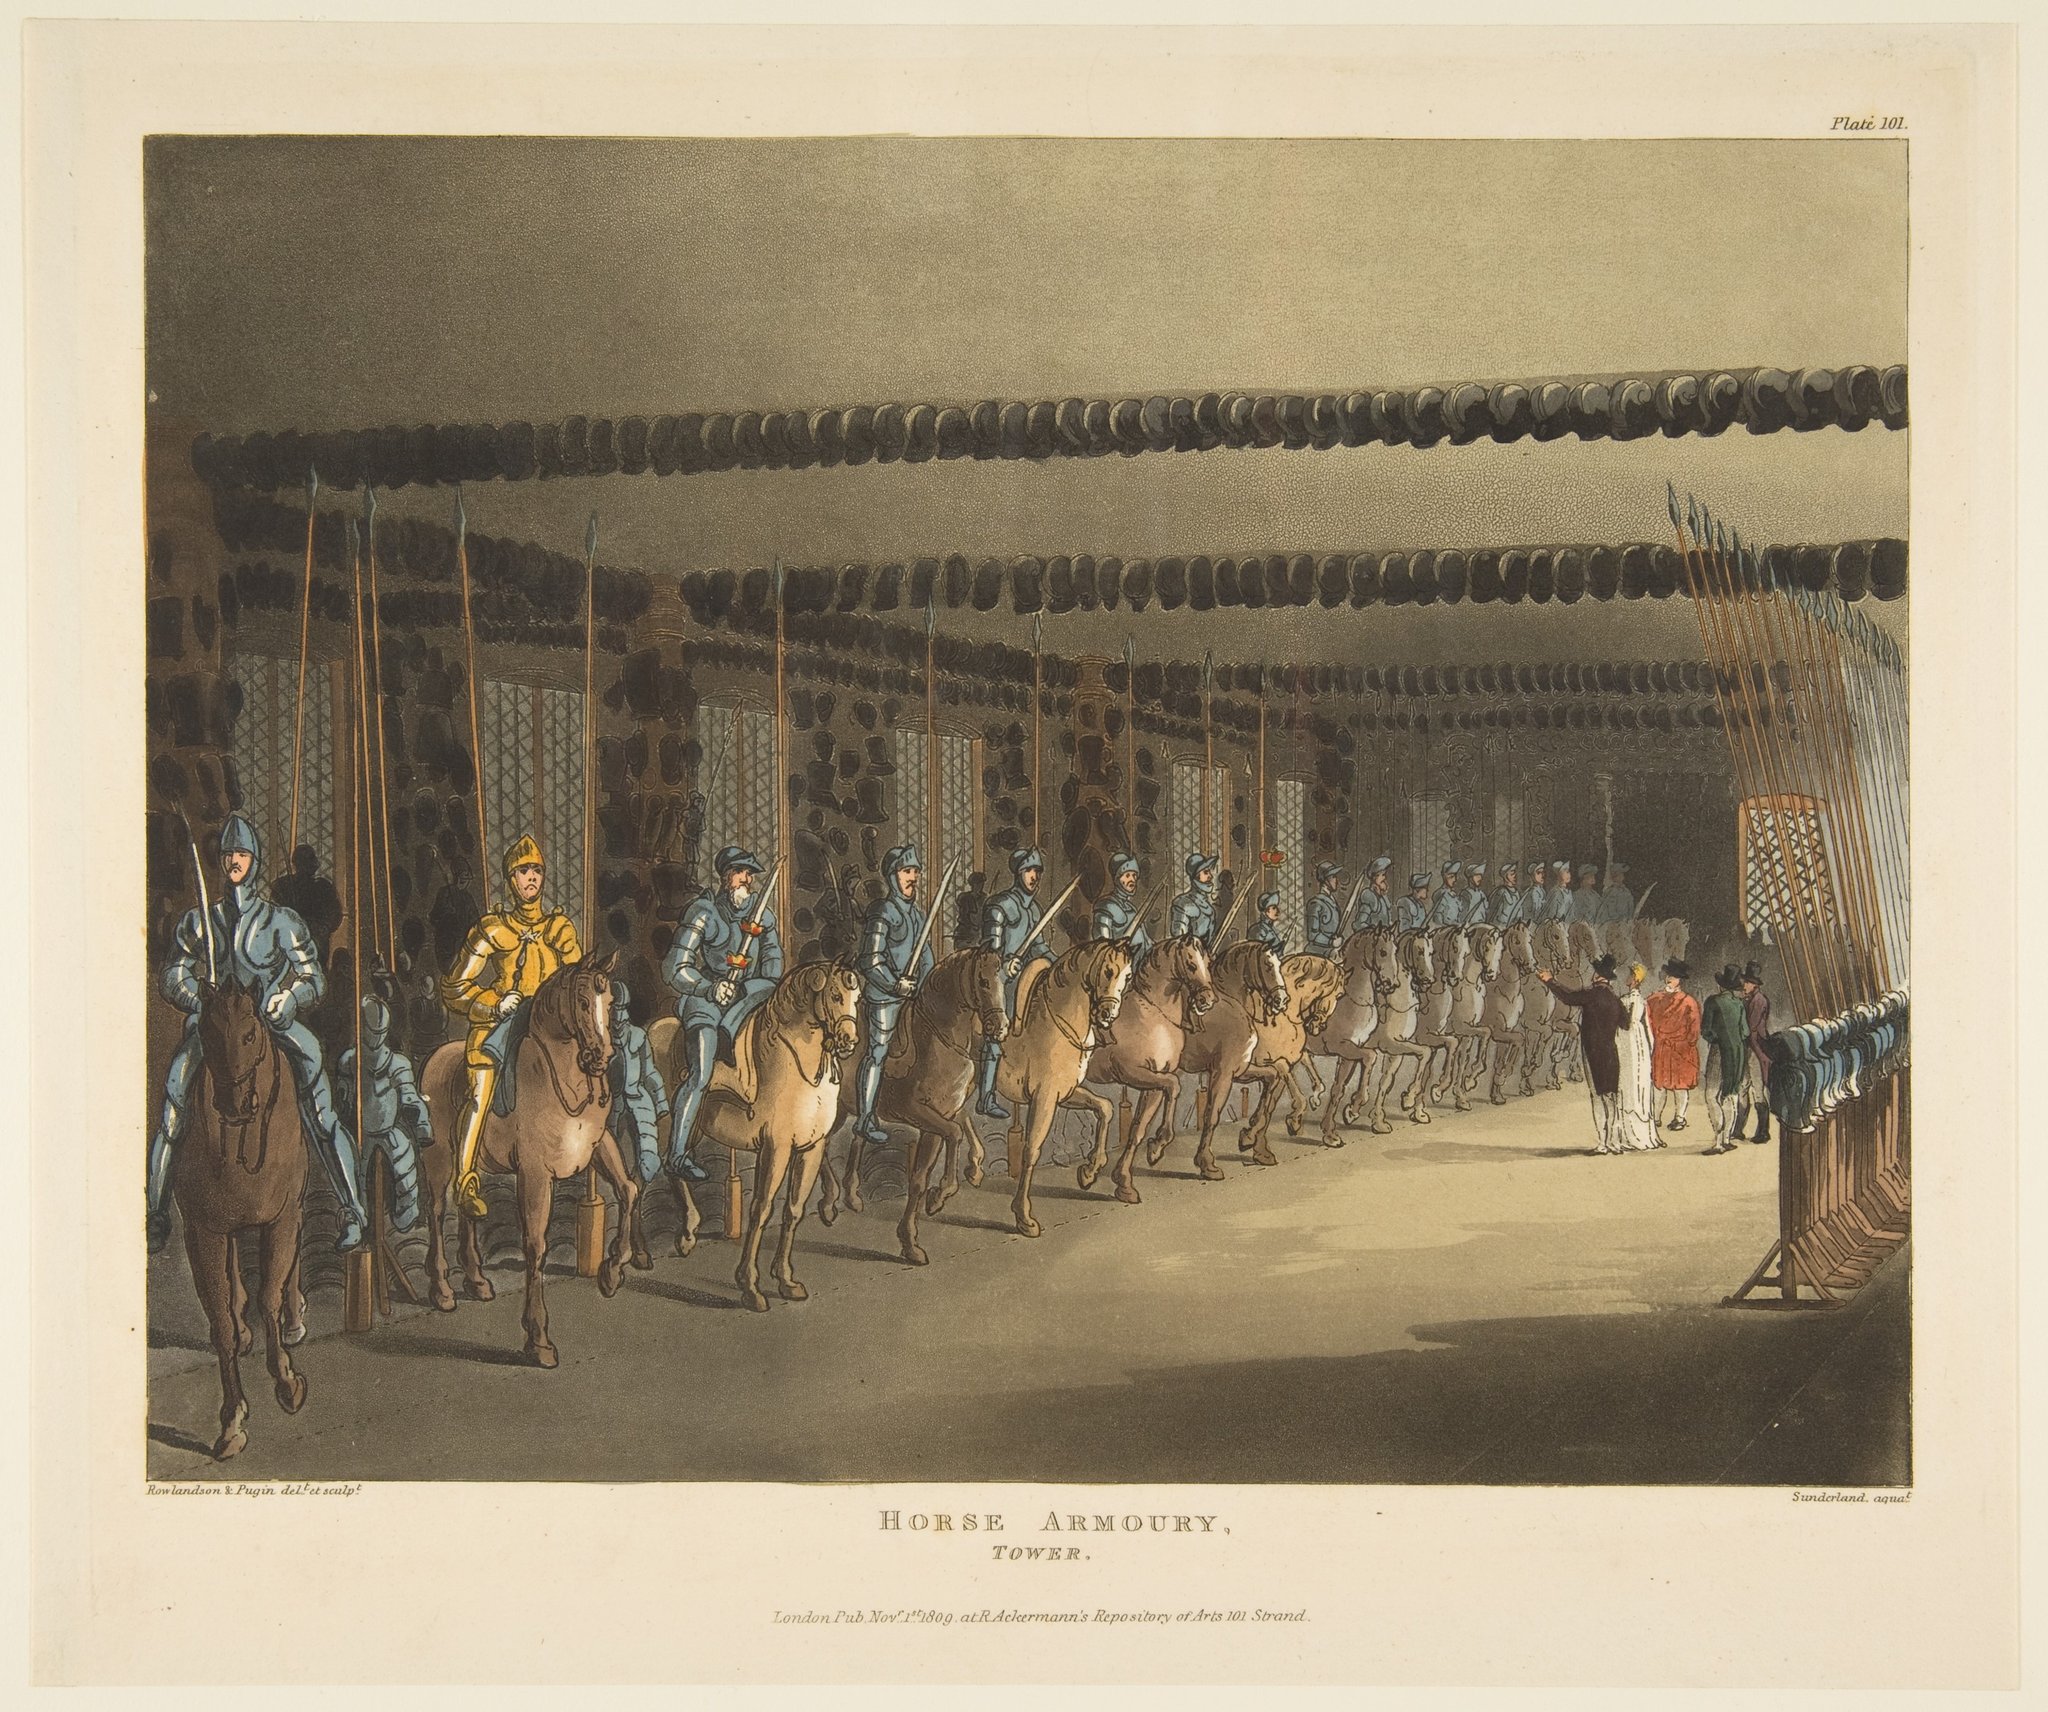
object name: print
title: Horse Armoury, Tower of London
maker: thomas rowlandson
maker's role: artist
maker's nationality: british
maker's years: 1757-1827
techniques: aquatint, etching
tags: armor,spears,swords,men,horses